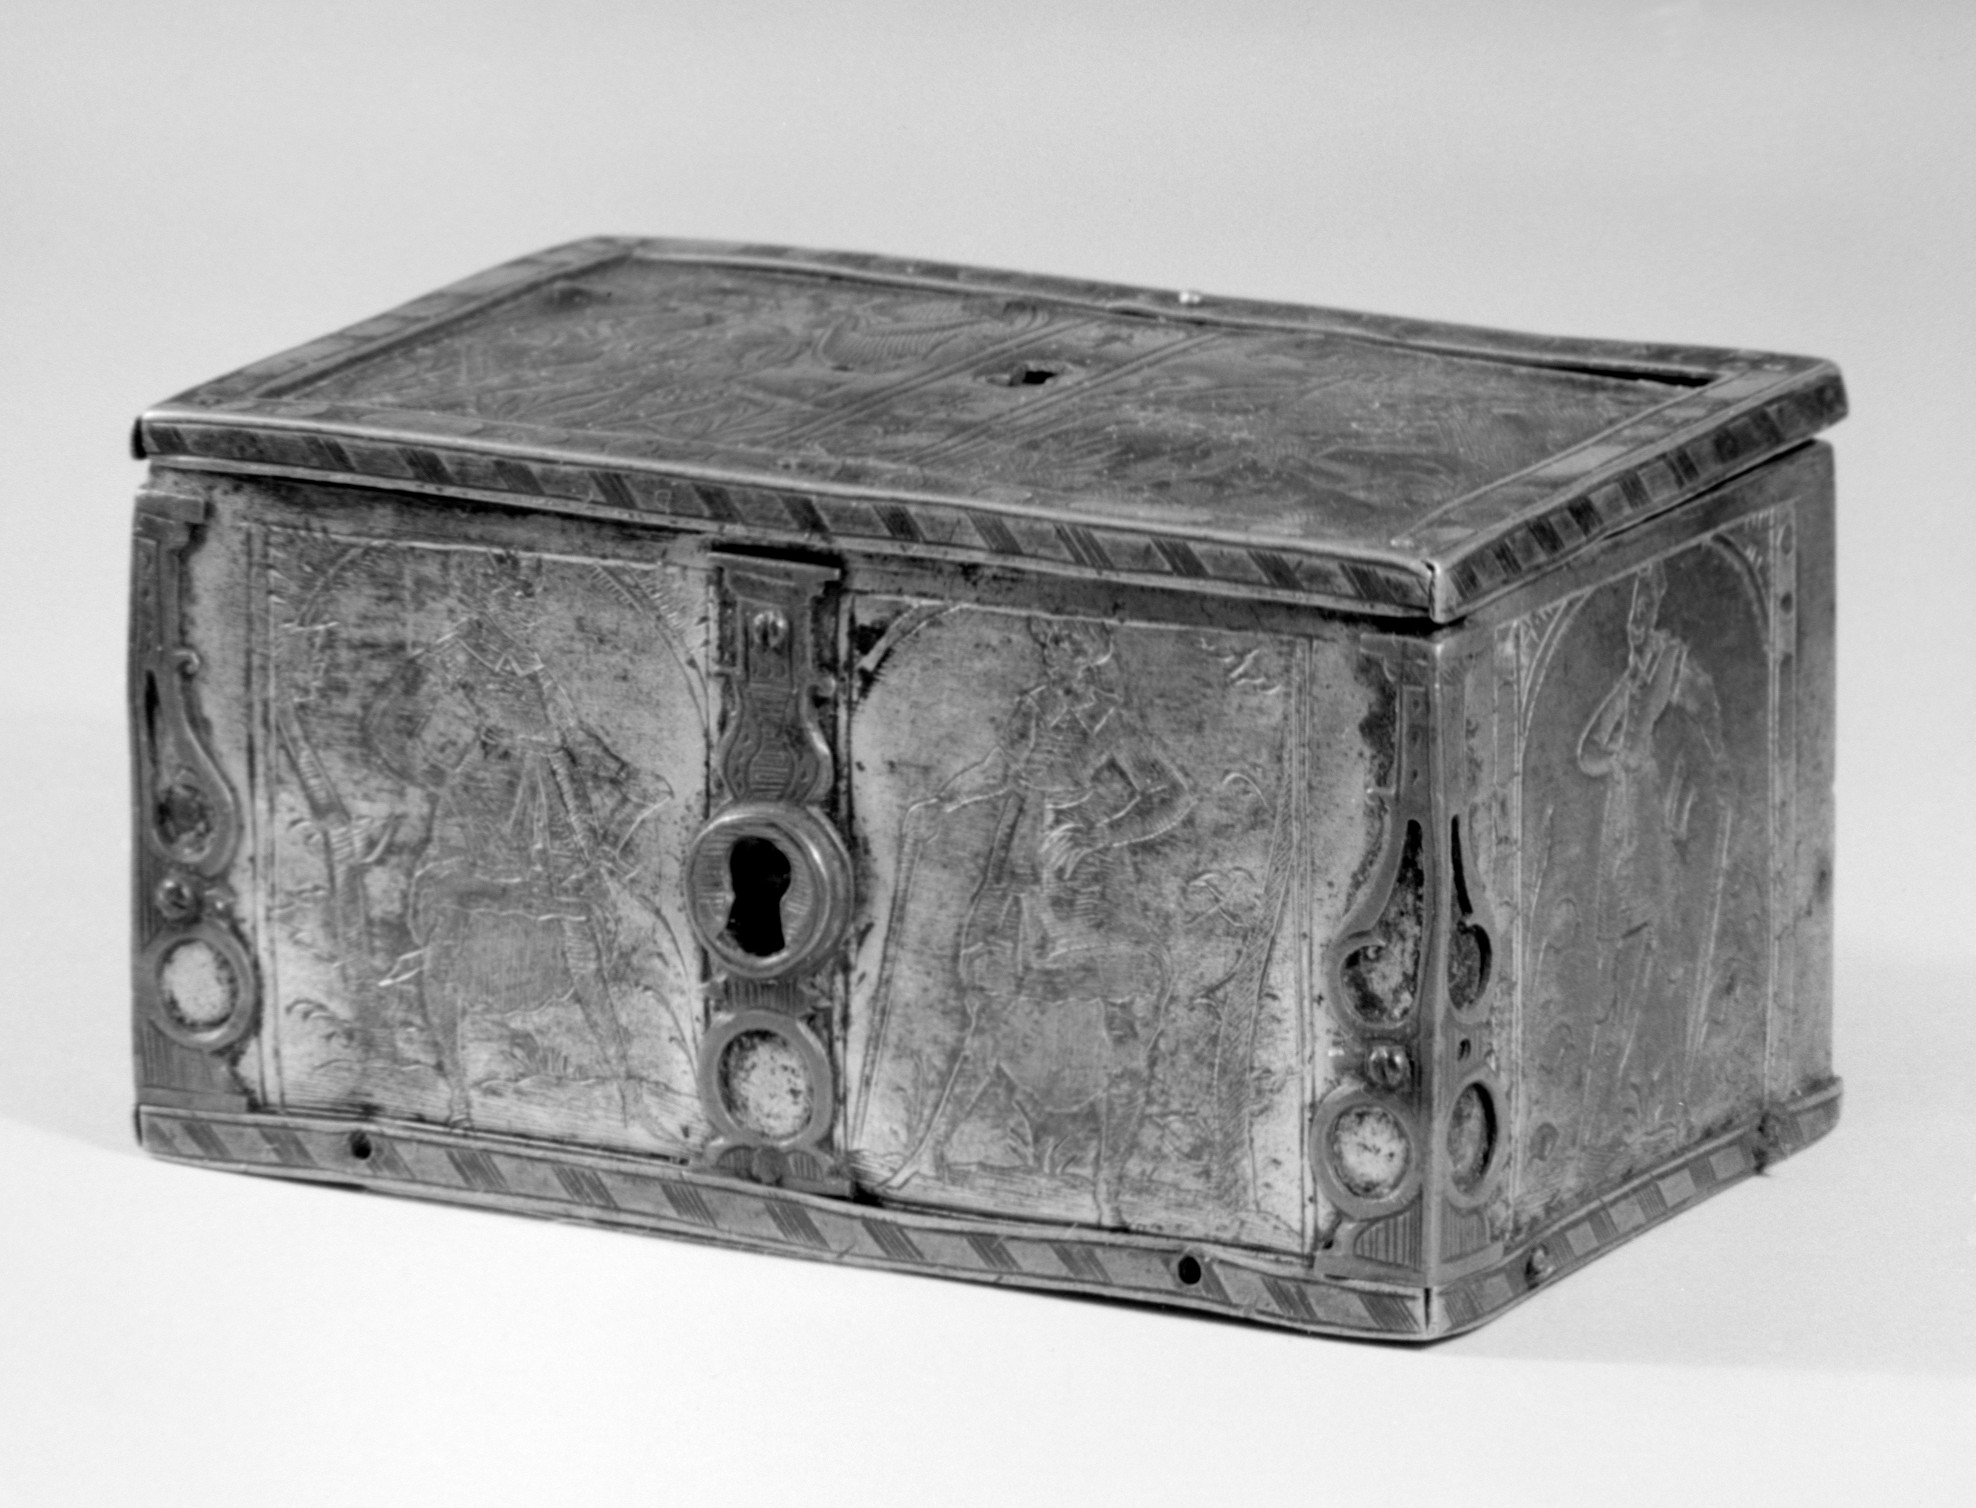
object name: coffret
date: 1601-1633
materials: brass, copper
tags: men